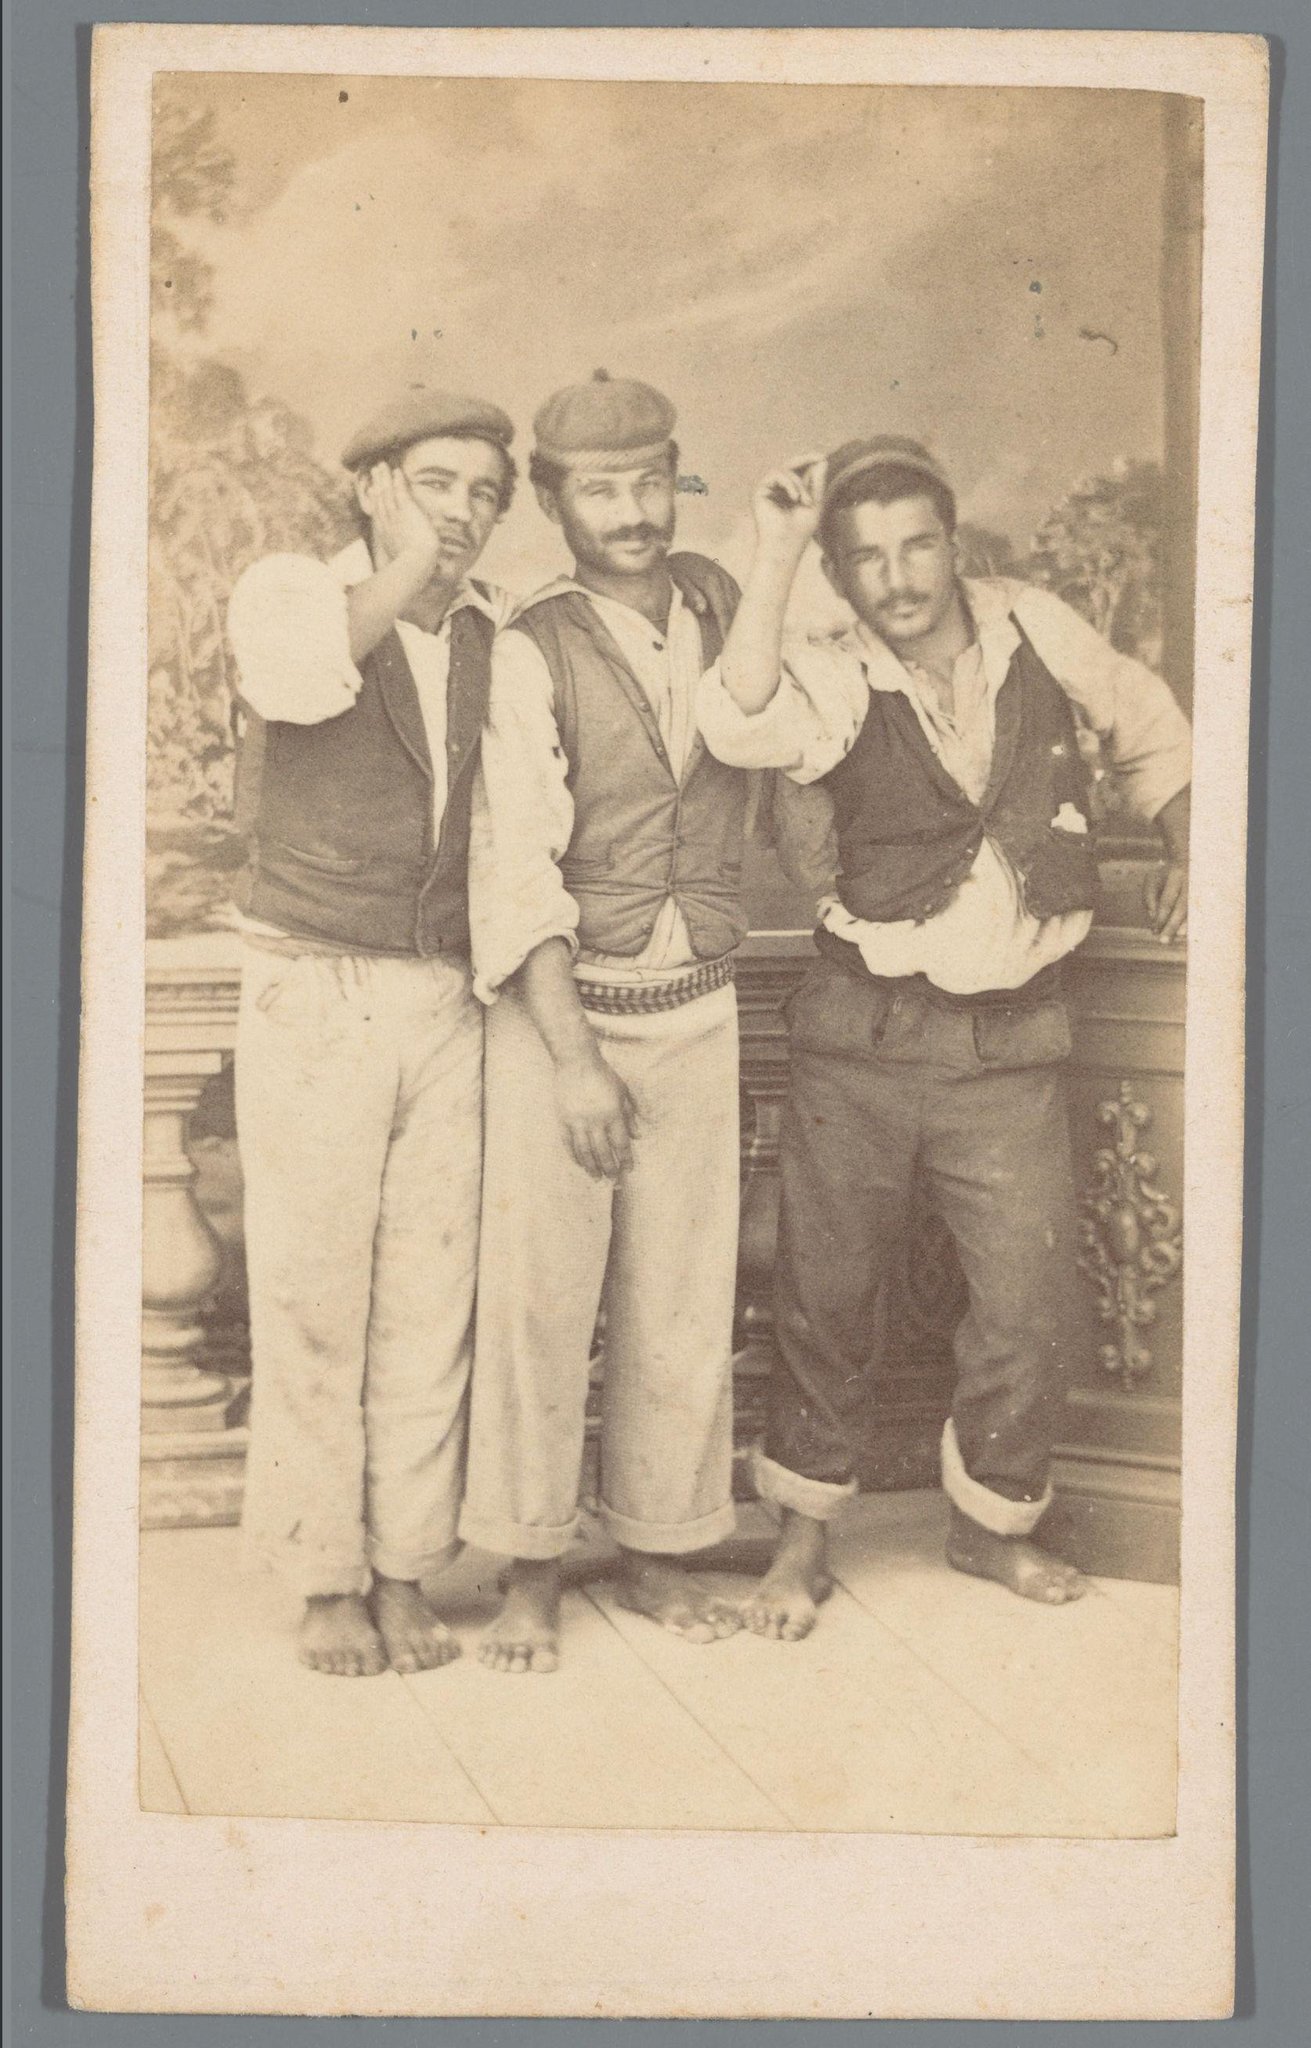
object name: photograph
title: Drie jonge Maltezen tegen geschilderde achtergrond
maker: Anonymous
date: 1855-1885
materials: cardboard, paper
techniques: albumen print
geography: valletta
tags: adult man, anonymous historical person portrayed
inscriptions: number: ‘1.00’, inscription: ‘Malta Valletta/ Str. Vescovo 163’